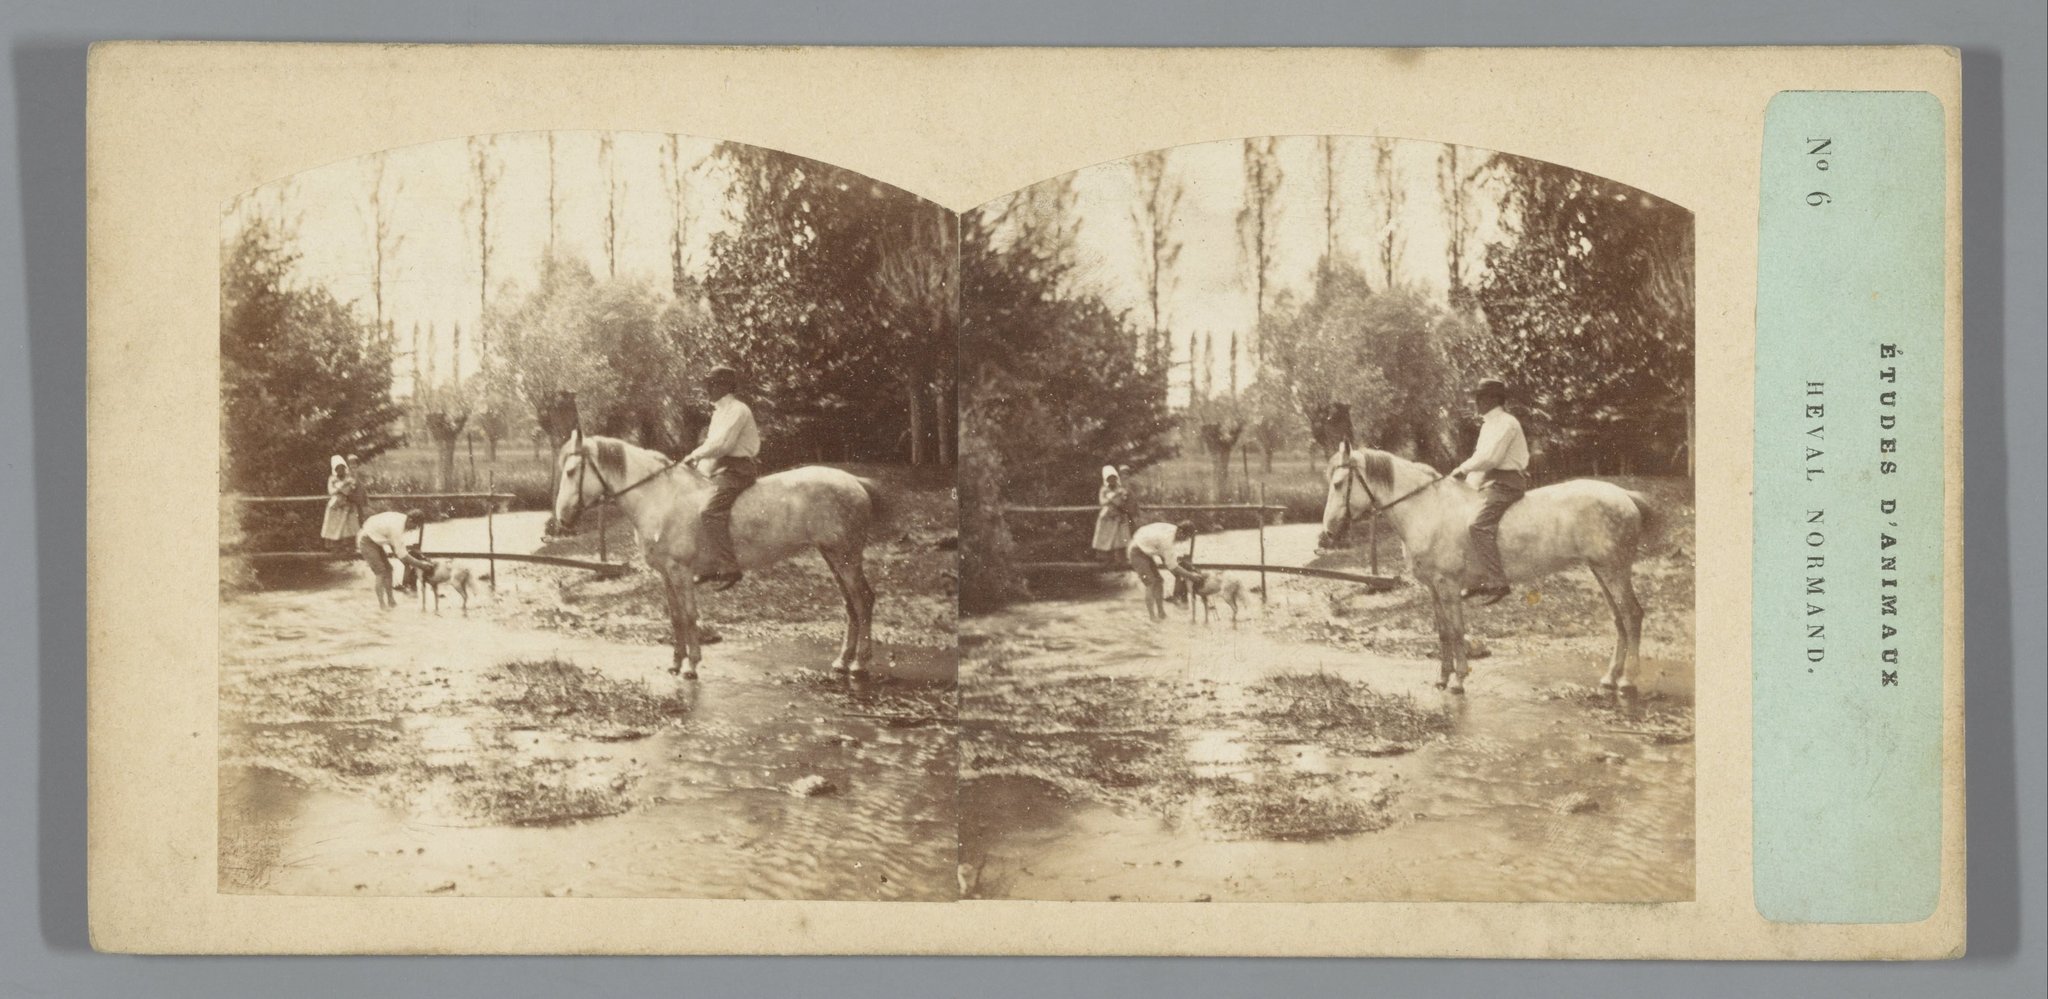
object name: stereograph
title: Études d'animaux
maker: Anonymous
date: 1857-1863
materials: cardboard, paper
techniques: albumen print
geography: france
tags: horse, france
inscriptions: inscription: ‘No VI A:W: Thöne No 19.’, number: ‘No 6’